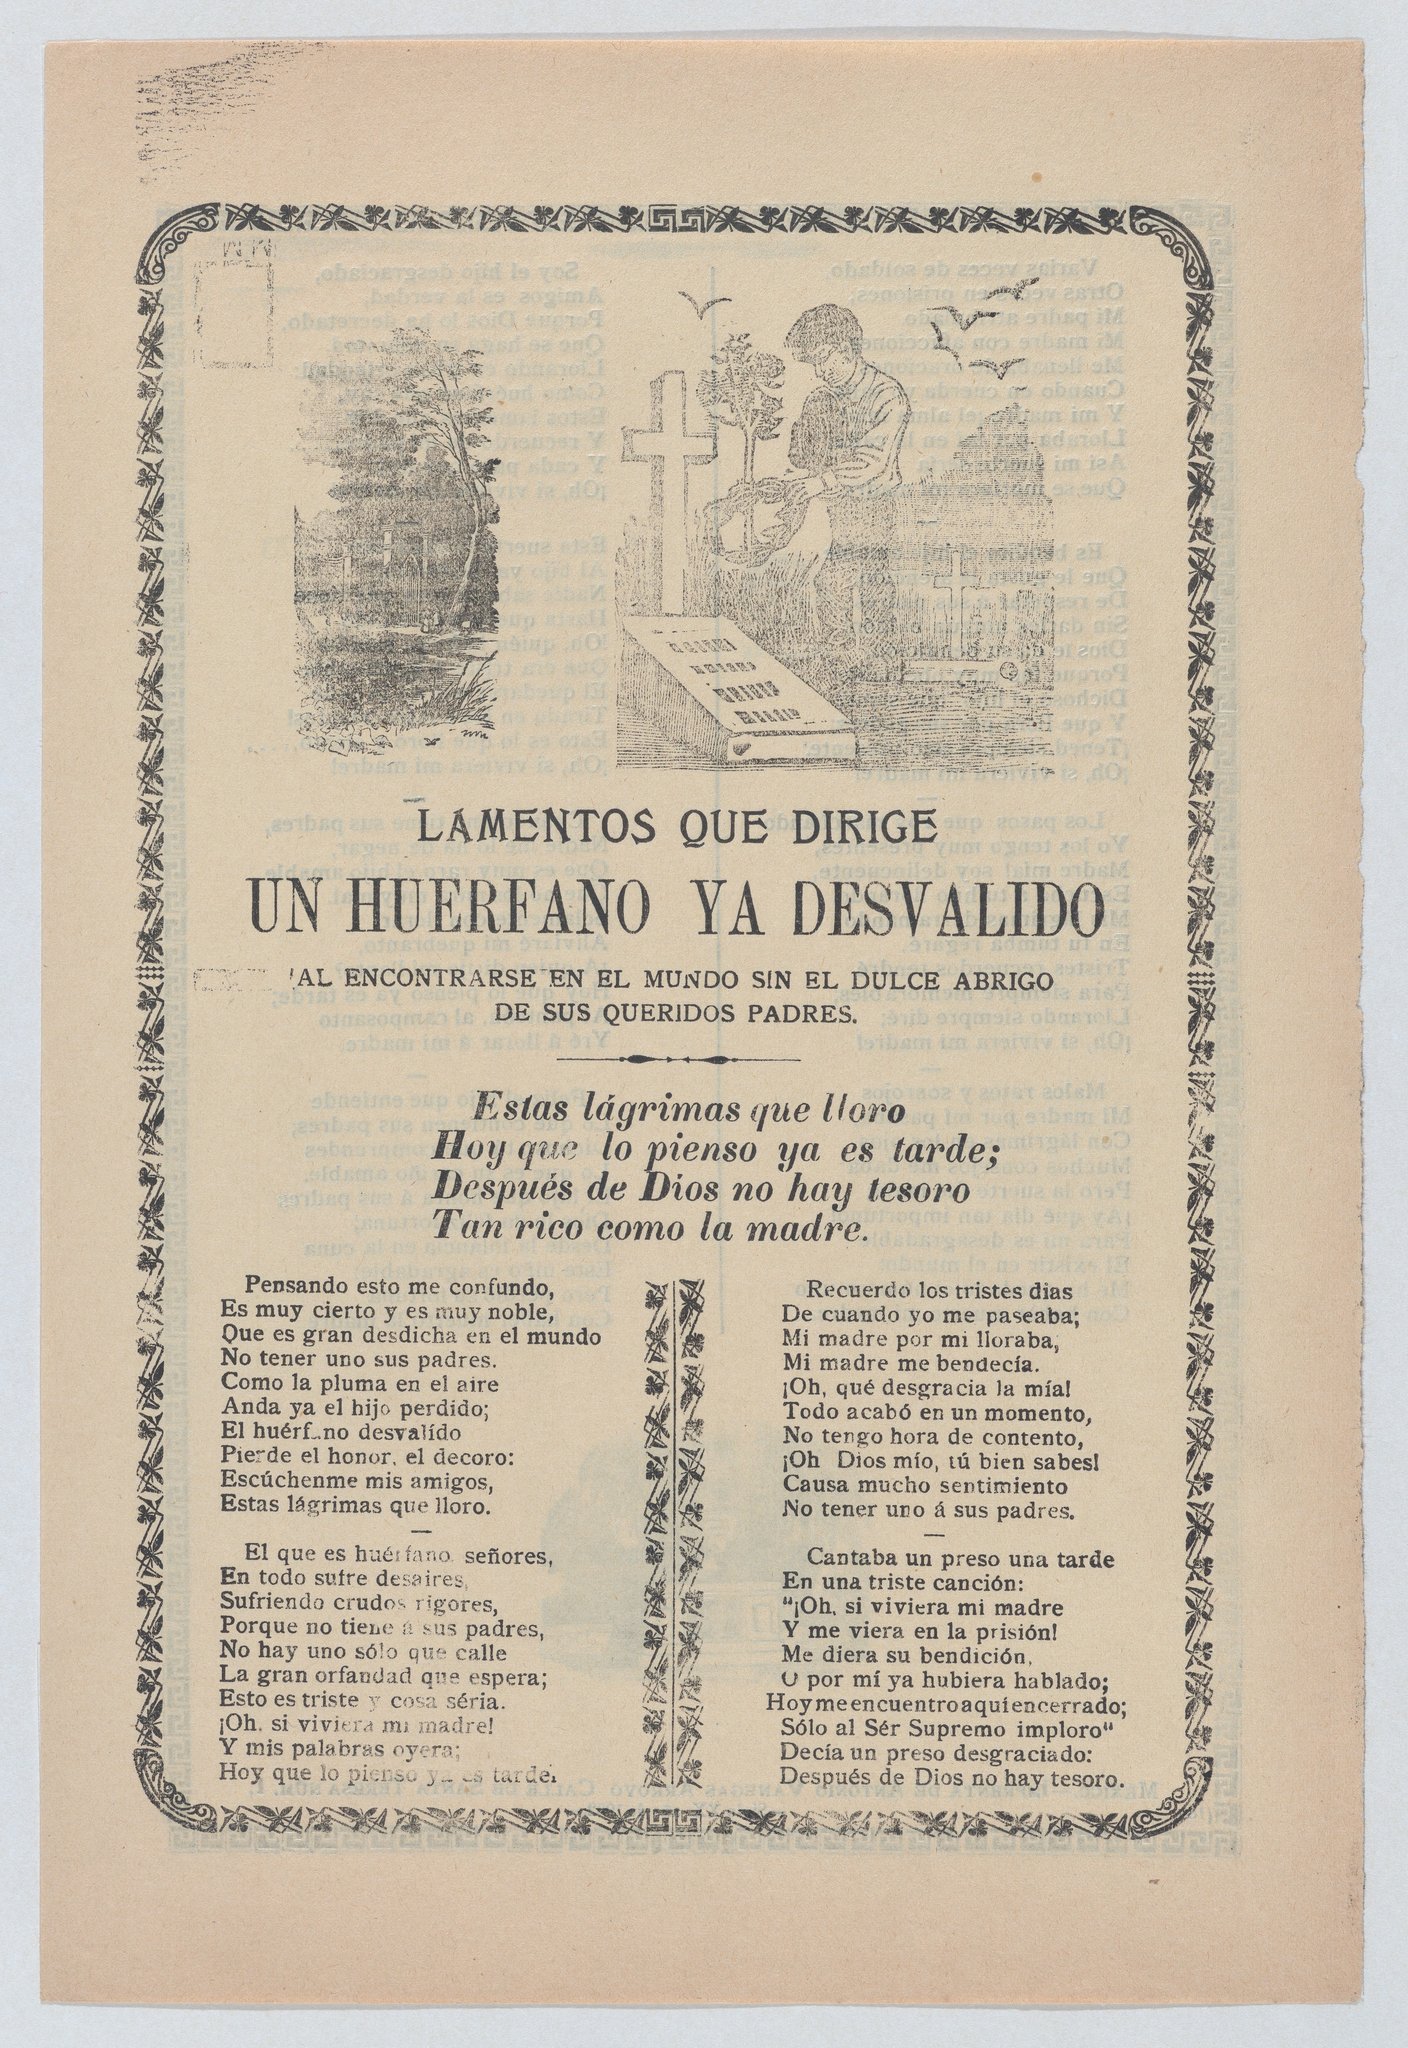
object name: print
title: Broadsheet relating to the plight of an orphan, young boy standing at the graves of his parents in a cemetery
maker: josé guadalupe posada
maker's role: artist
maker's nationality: mexican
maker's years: 1852-1913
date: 1900-1913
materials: paper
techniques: letterpress, lithography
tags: burial grounds,boys